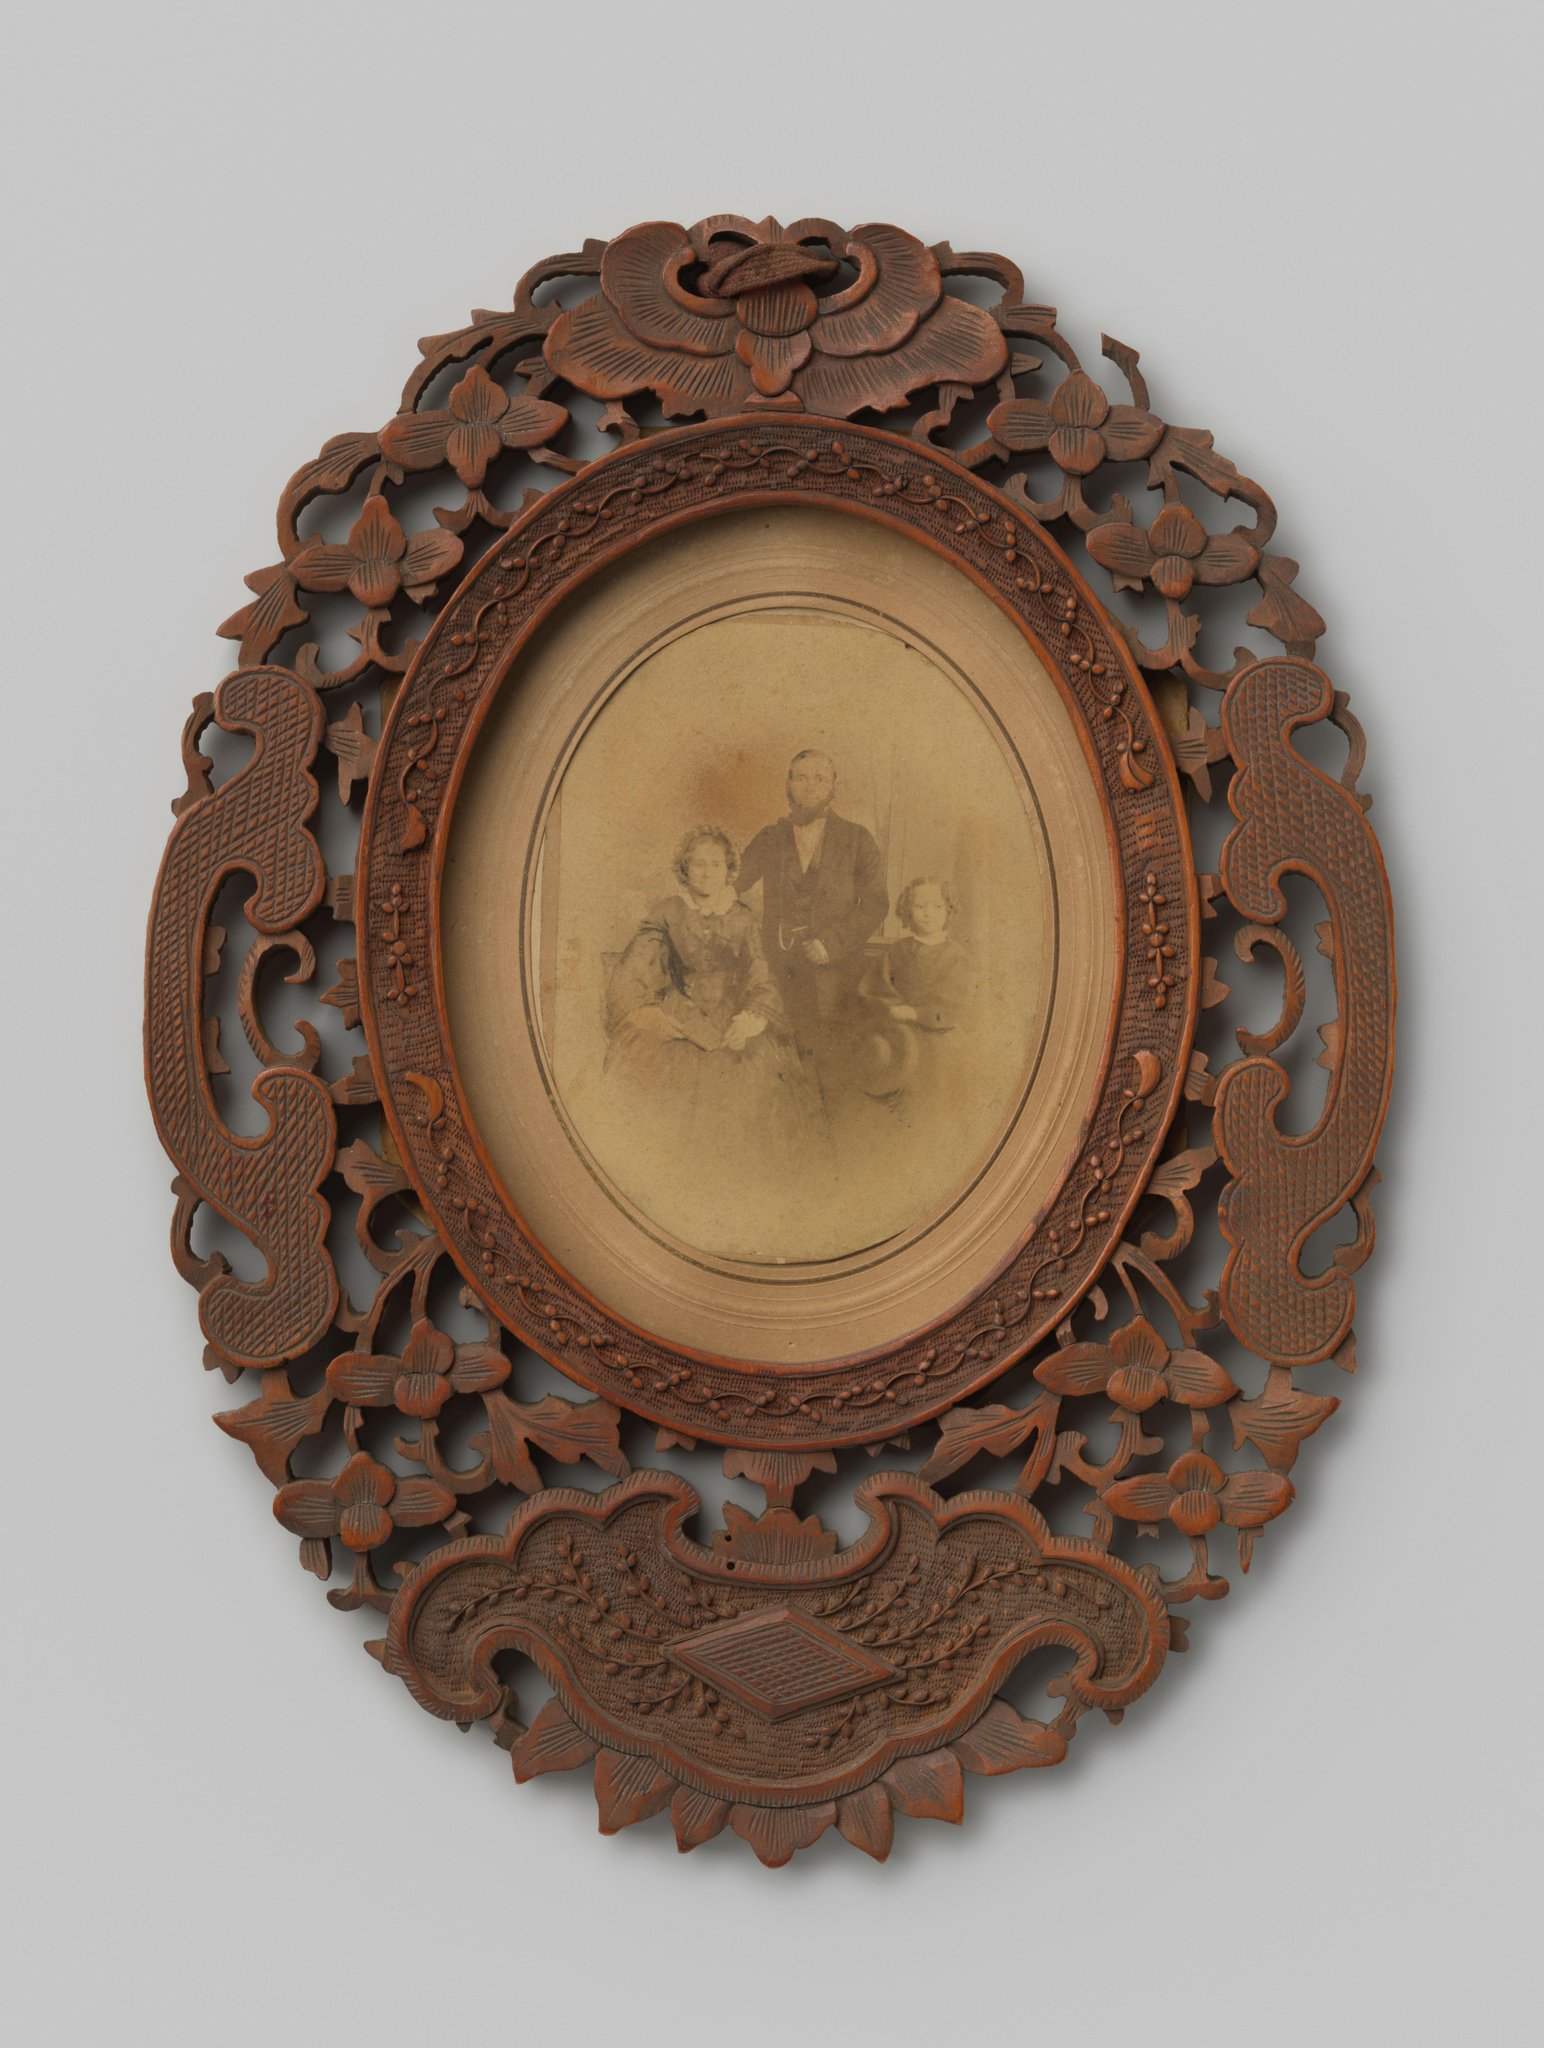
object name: photograph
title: Portret van Johann, Johanna en Auguste Borrasch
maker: Anonymous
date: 1860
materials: cardboard, glass, paper, wood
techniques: albumen print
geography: danzig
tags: parents with their children, historical persons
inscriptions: inscription: ‘Johann Borrasch/ geb. 18/9 1816 gest 2/10 1872/ Johanna Borrasch geb. Bartels/ geb. 4/8 1816 gest. 21/5 1893/ Auguste Borrasch 20/12 54/ geb. 20/12 gest. 30/8 1930/ Bild aufnahm 1860/ Danzig’